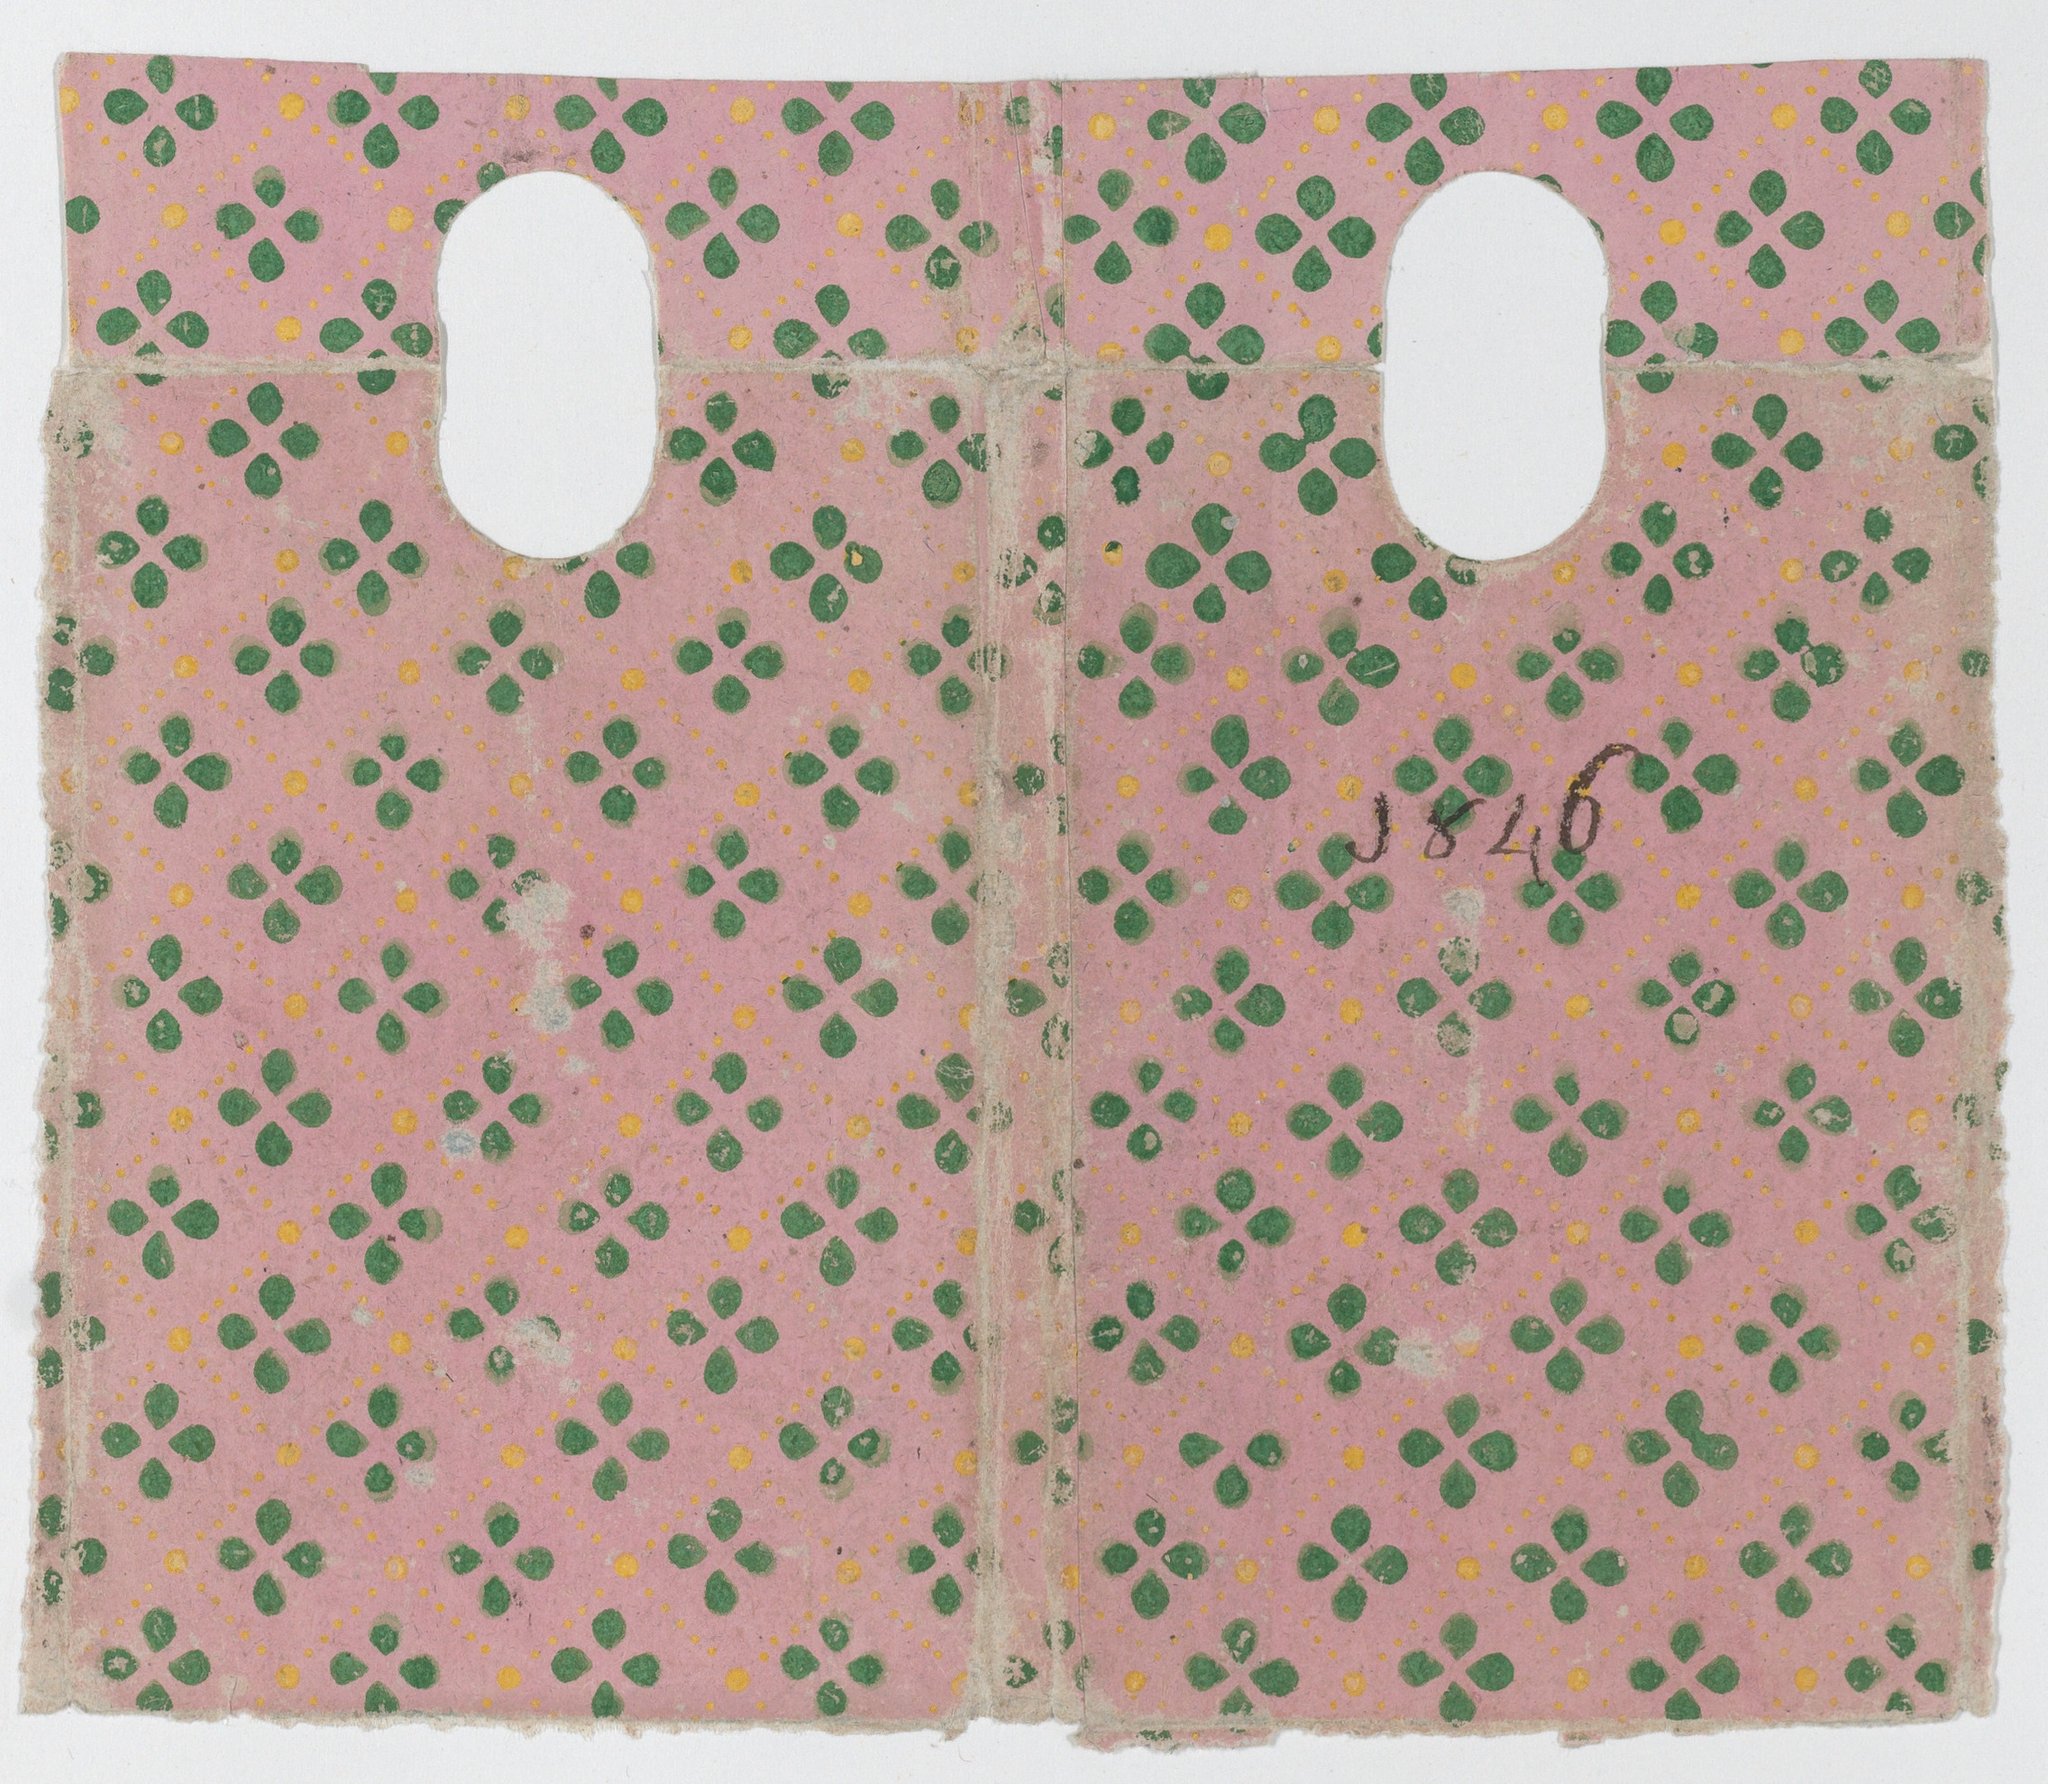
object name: print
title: Sheet with an overall floral and dot pattern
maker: Anonymous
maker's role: artist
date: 1836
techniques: relief print